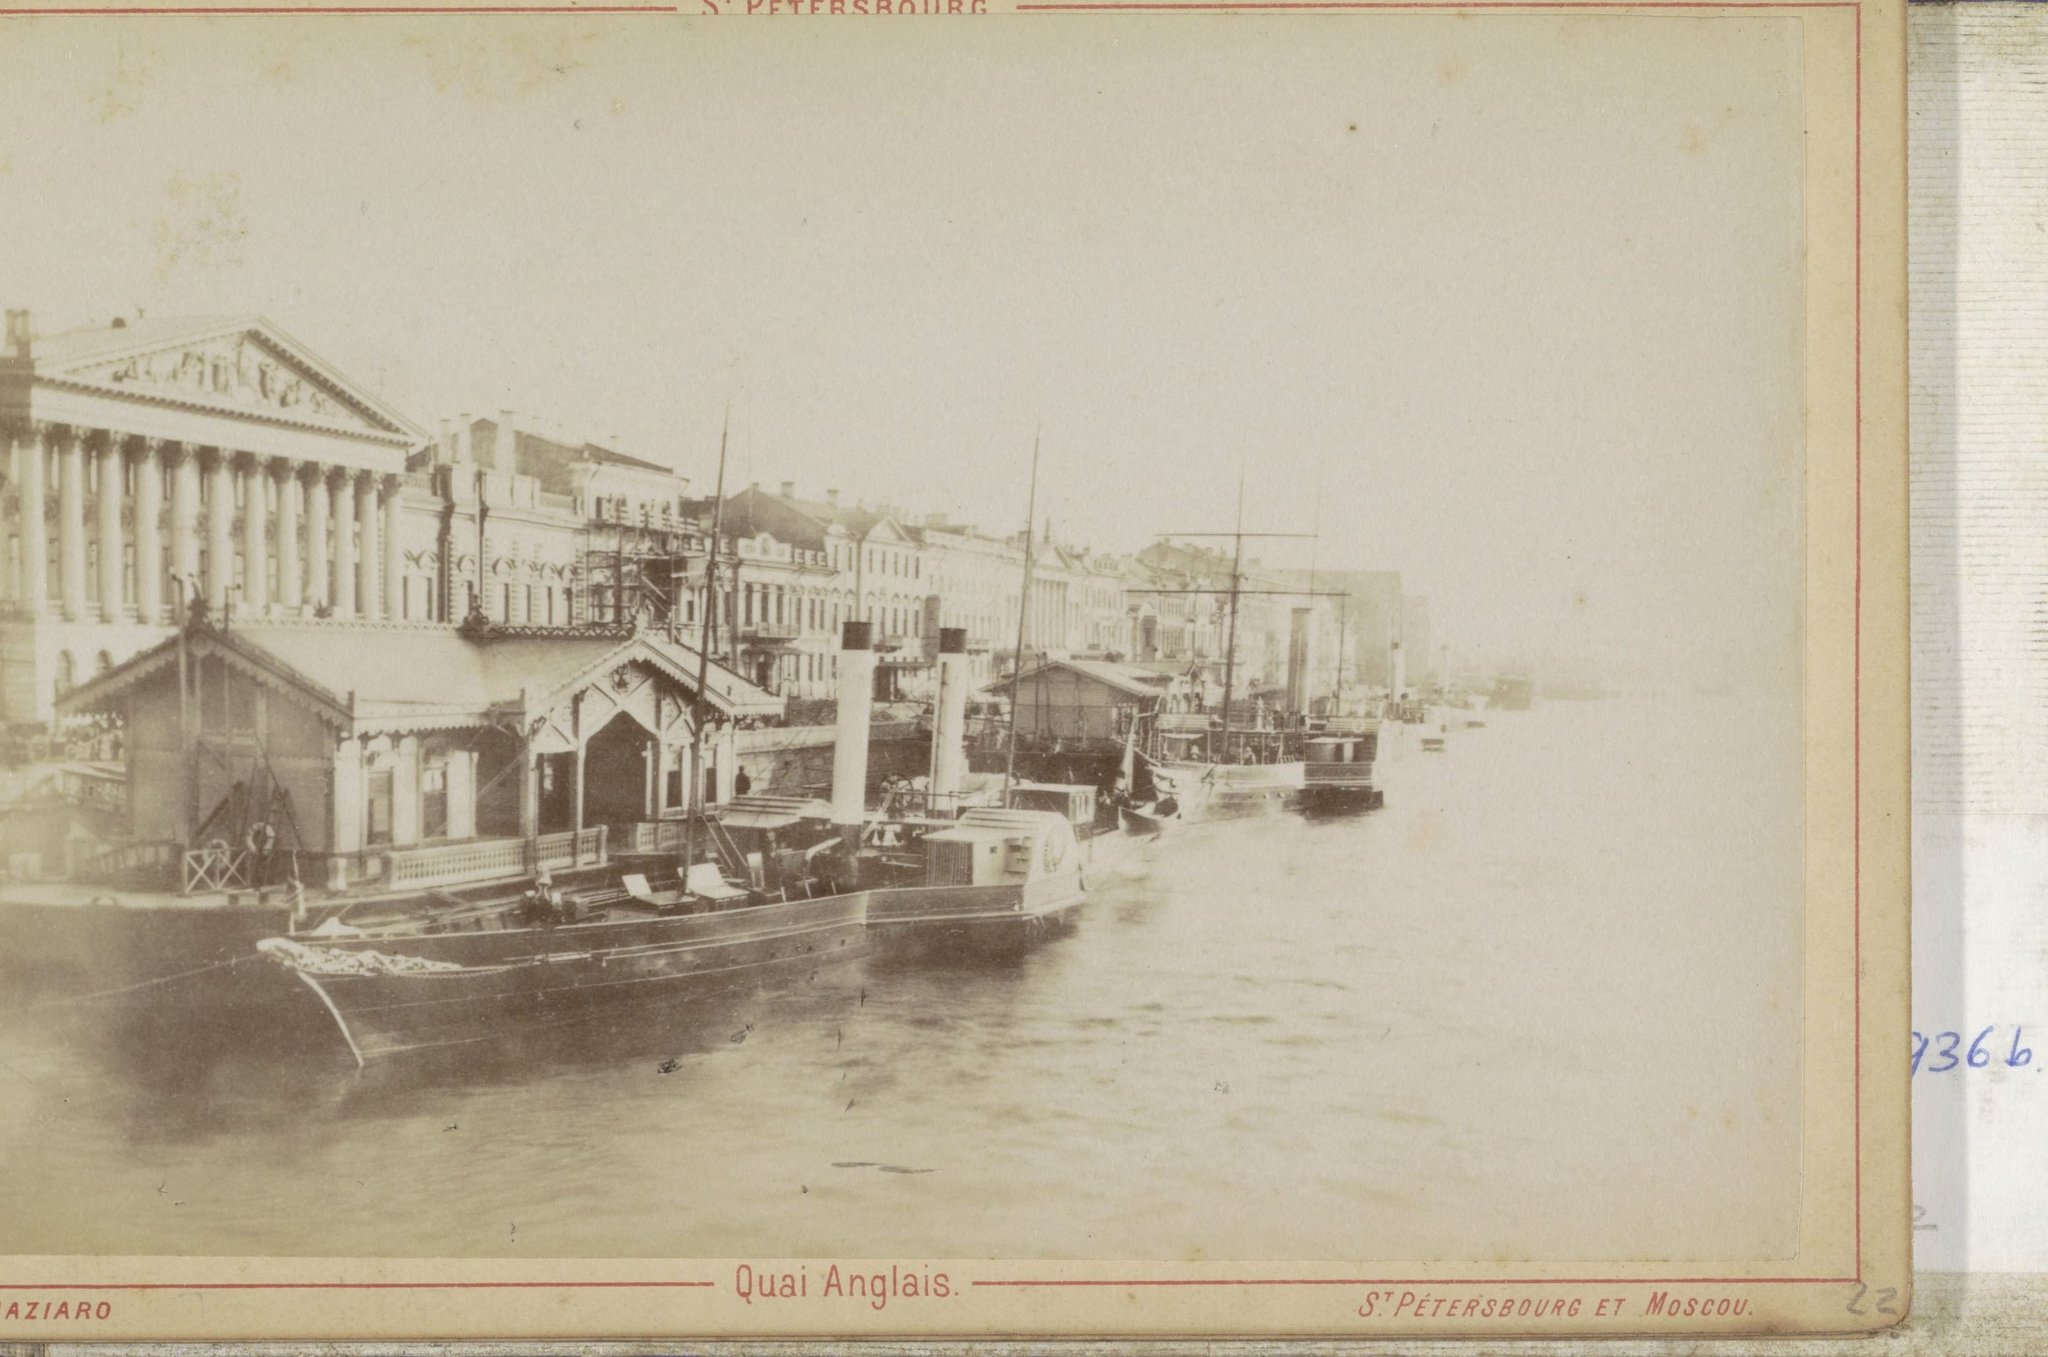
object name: photograph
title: St. Pétersbourg. Quai Anglais.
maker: joseph daziaro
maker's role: publisher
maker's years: 1831-1892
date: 1880-1900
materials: cardboard, photographic support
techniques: albumen print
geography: sint-petersburg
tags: quay (+ city(-scape) with figures, staffage), paddle-wheel boat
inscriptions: inscription: ‘22.’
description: Onderdeel van Leporelloalbum met opnames van Sint-Petersburg.